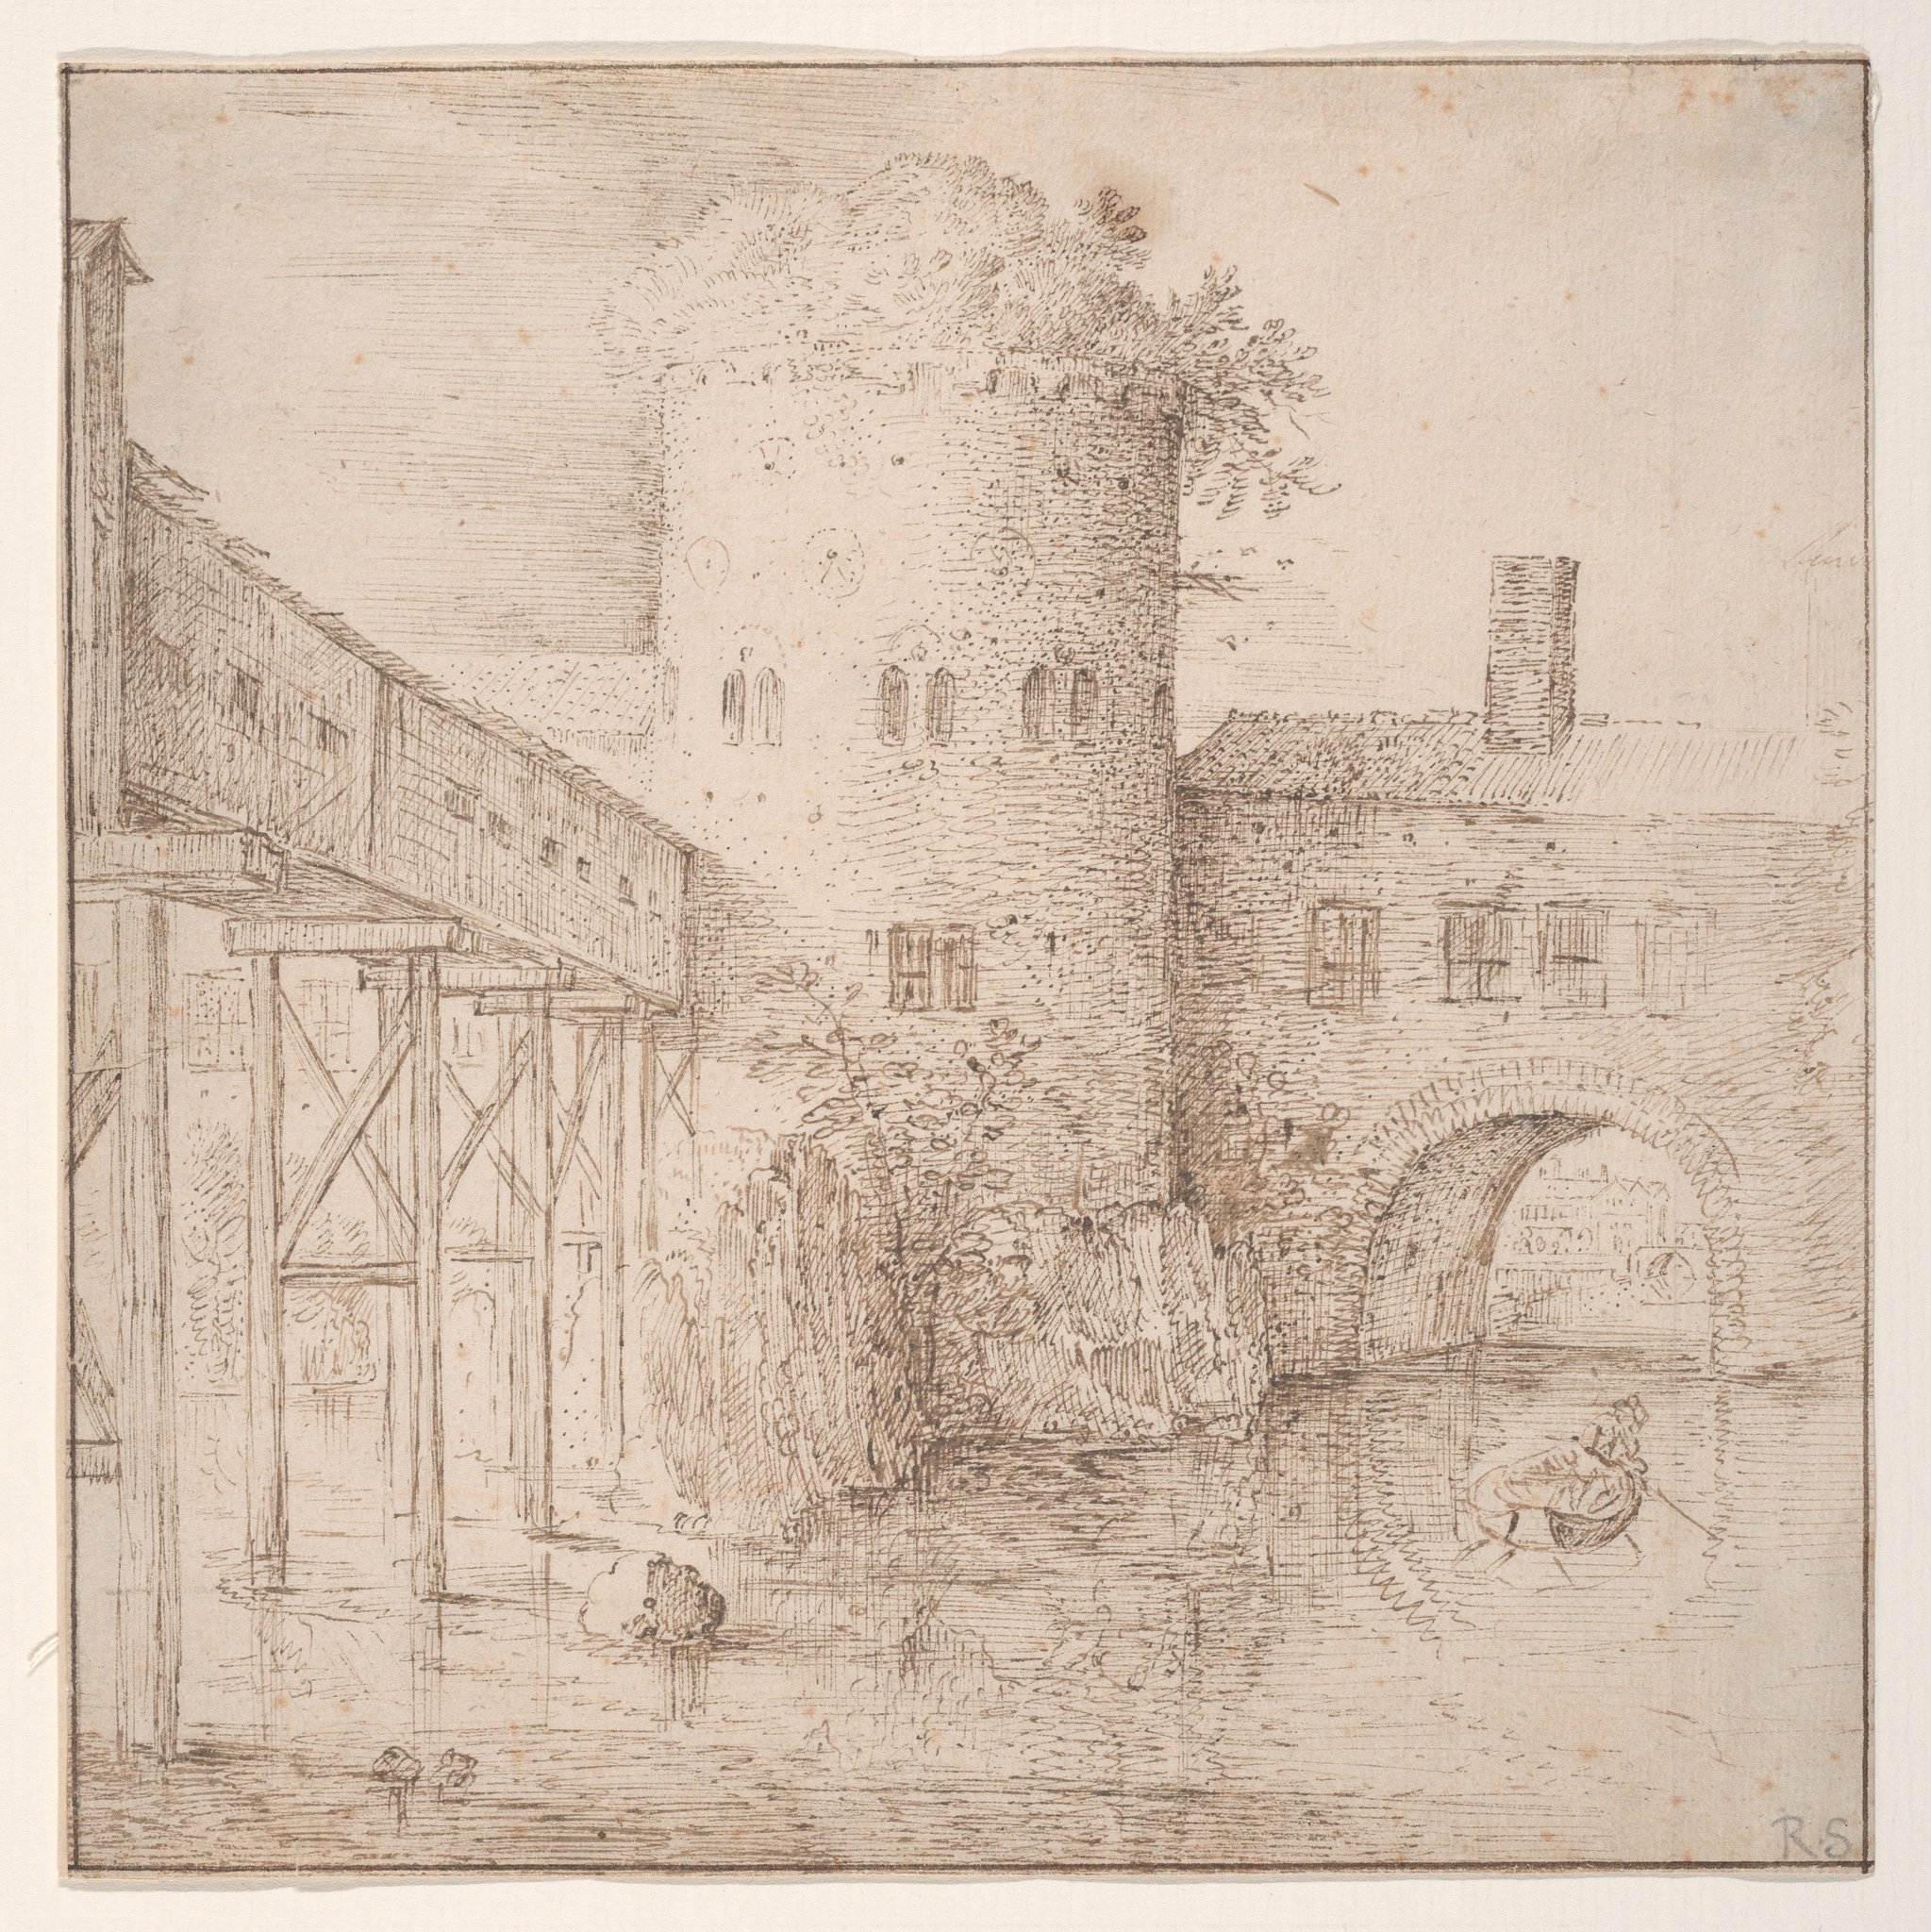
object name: drawing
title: A Mill with a Fortified Bridge, a Rowing Boat in the Foreground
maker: roelandt savery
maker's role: artist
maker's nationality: flemish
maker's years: 1576-1639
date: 1596-1639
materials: ink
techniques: pen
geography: netherlands